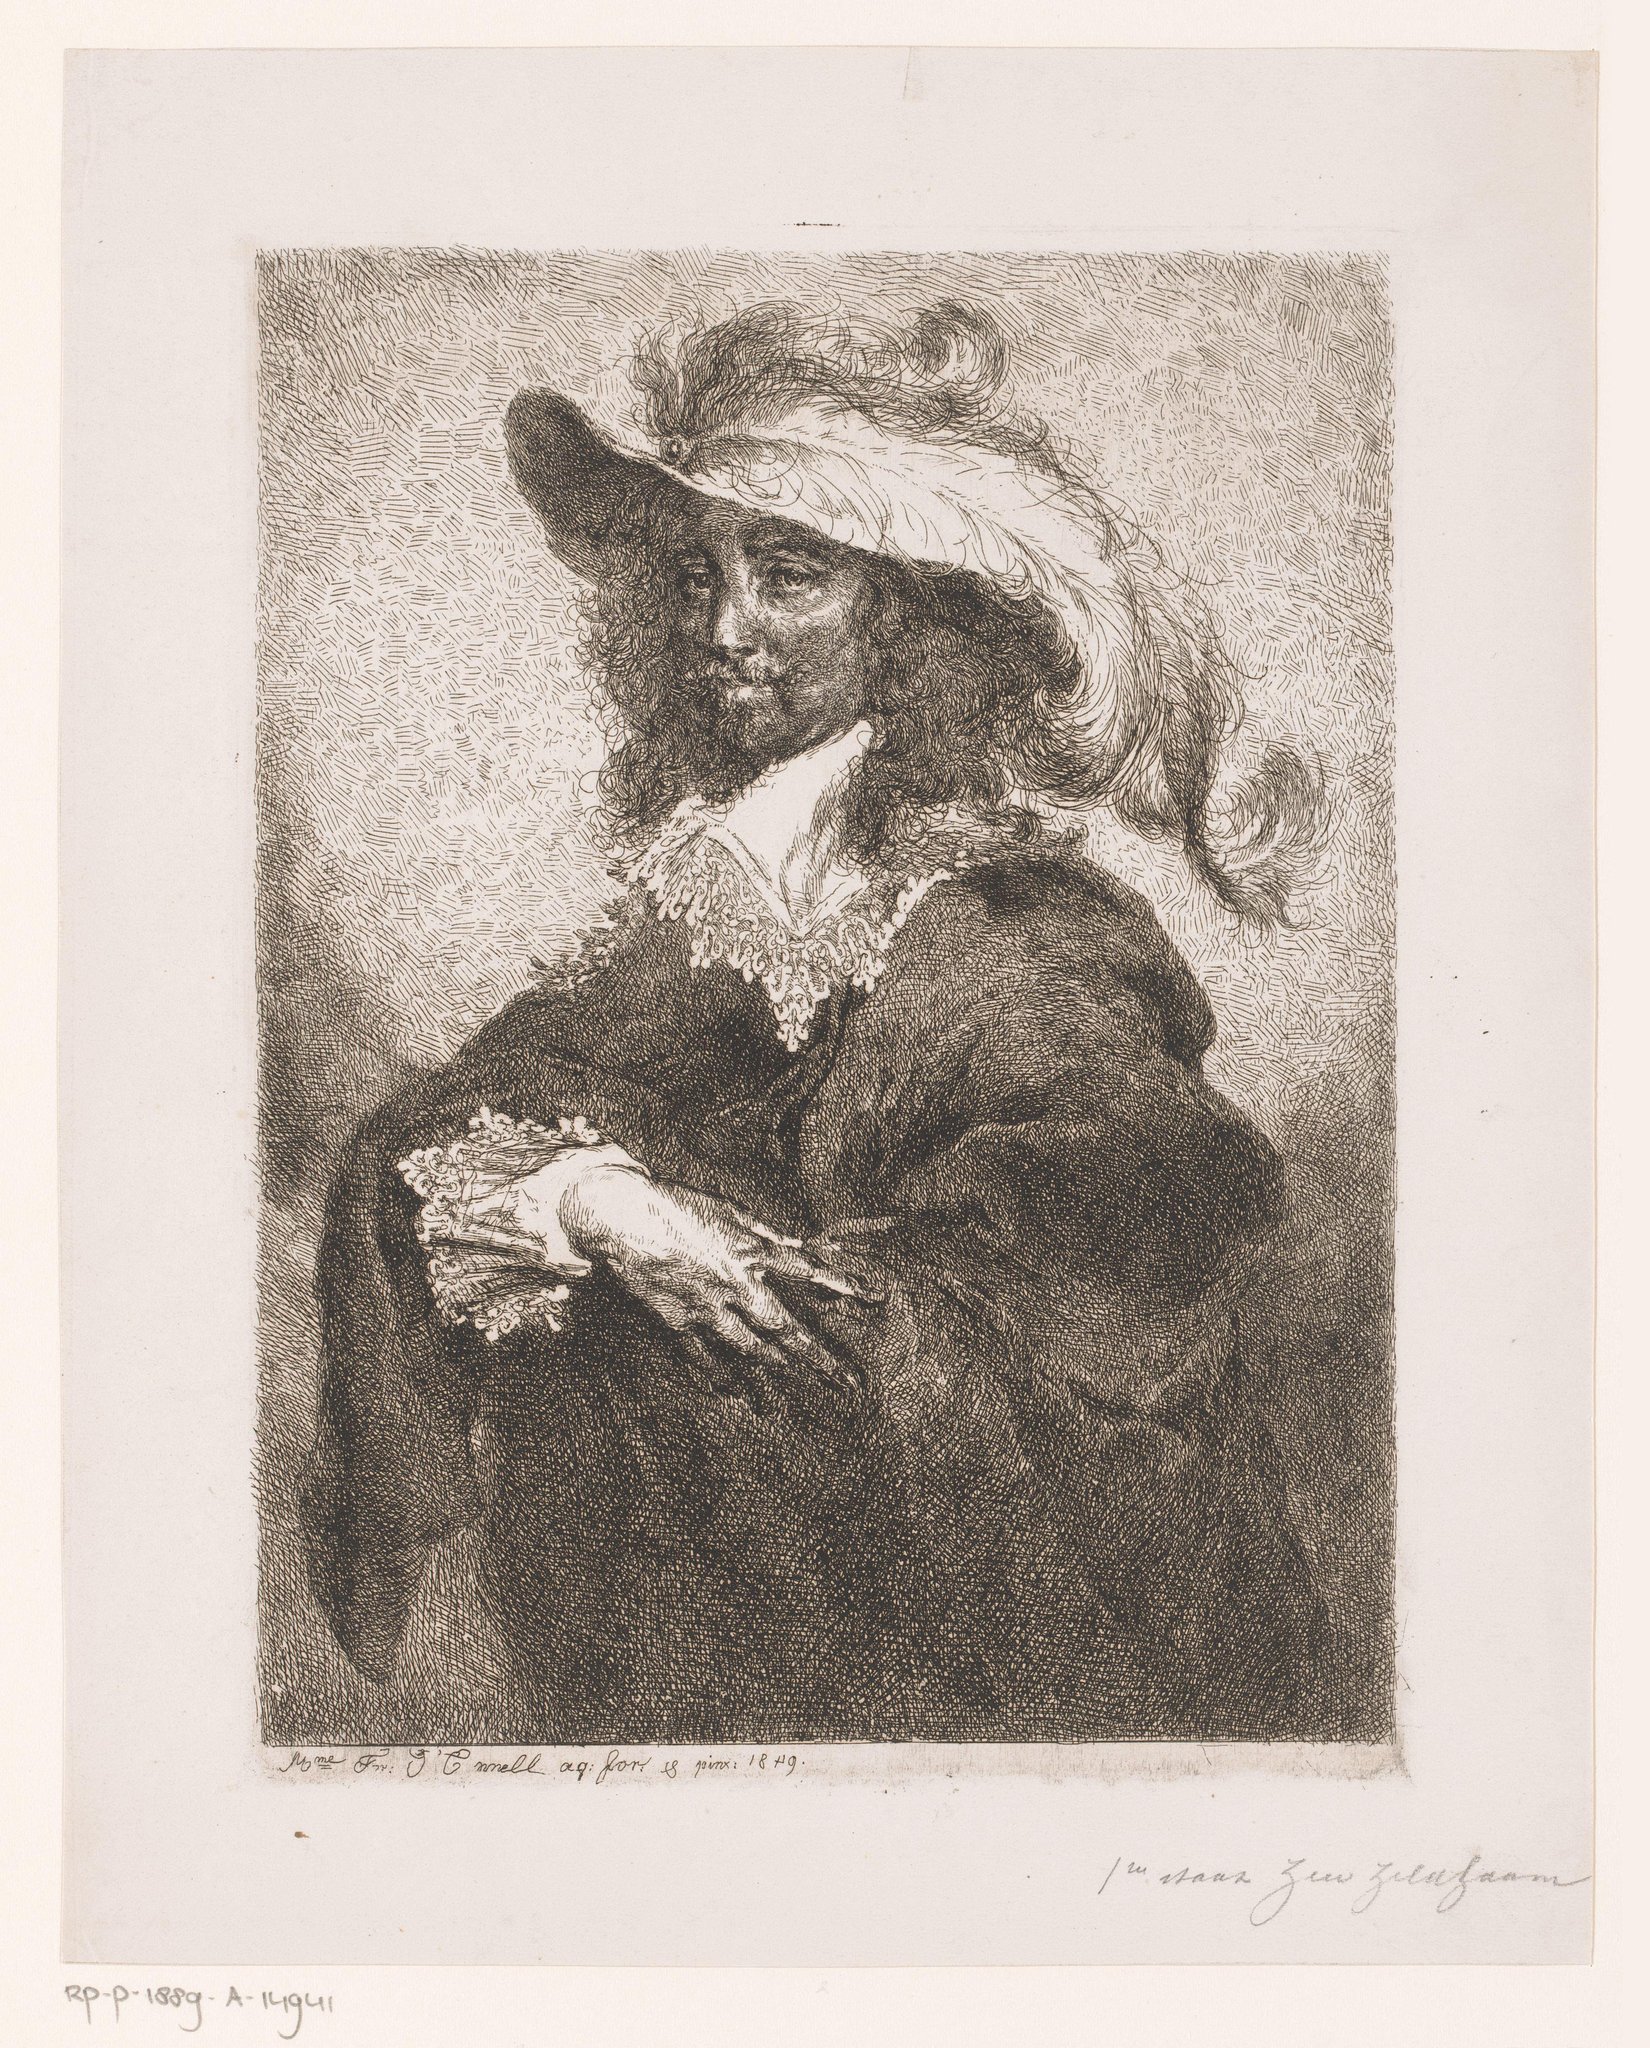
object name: print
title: Edelman uit de tijd van Lodewijk XIII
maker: frédérique émile auguste oconnell-miethe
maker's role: print maker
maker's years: 1823-1885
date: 1849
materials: paper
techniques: etching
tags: anonymous historical person portrayed alone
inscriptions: annotation: ‘1ste staat zeer zeldzaam’, collector's mark: Lugt 2228